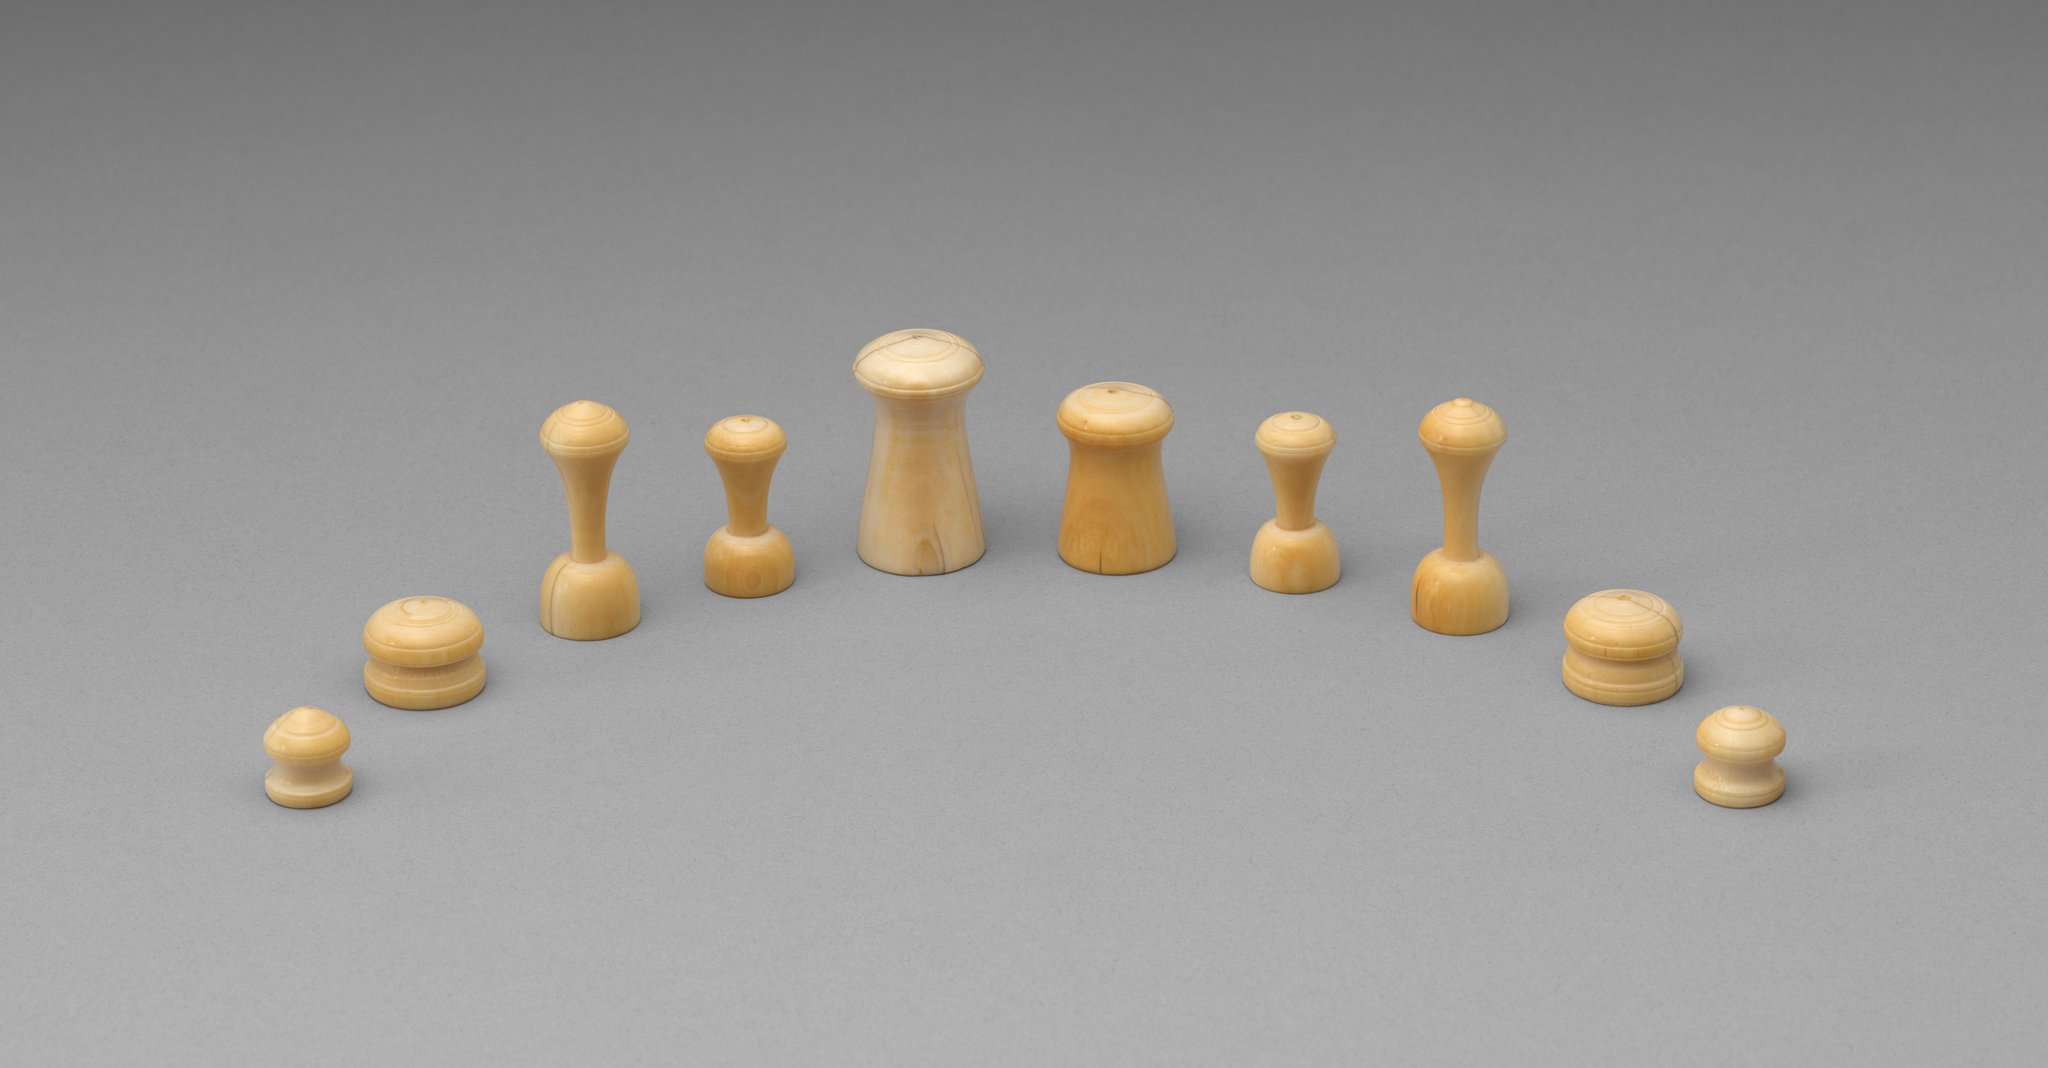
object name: chessman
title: Chessmen (32)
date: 1801-1900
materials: ivory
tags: chess